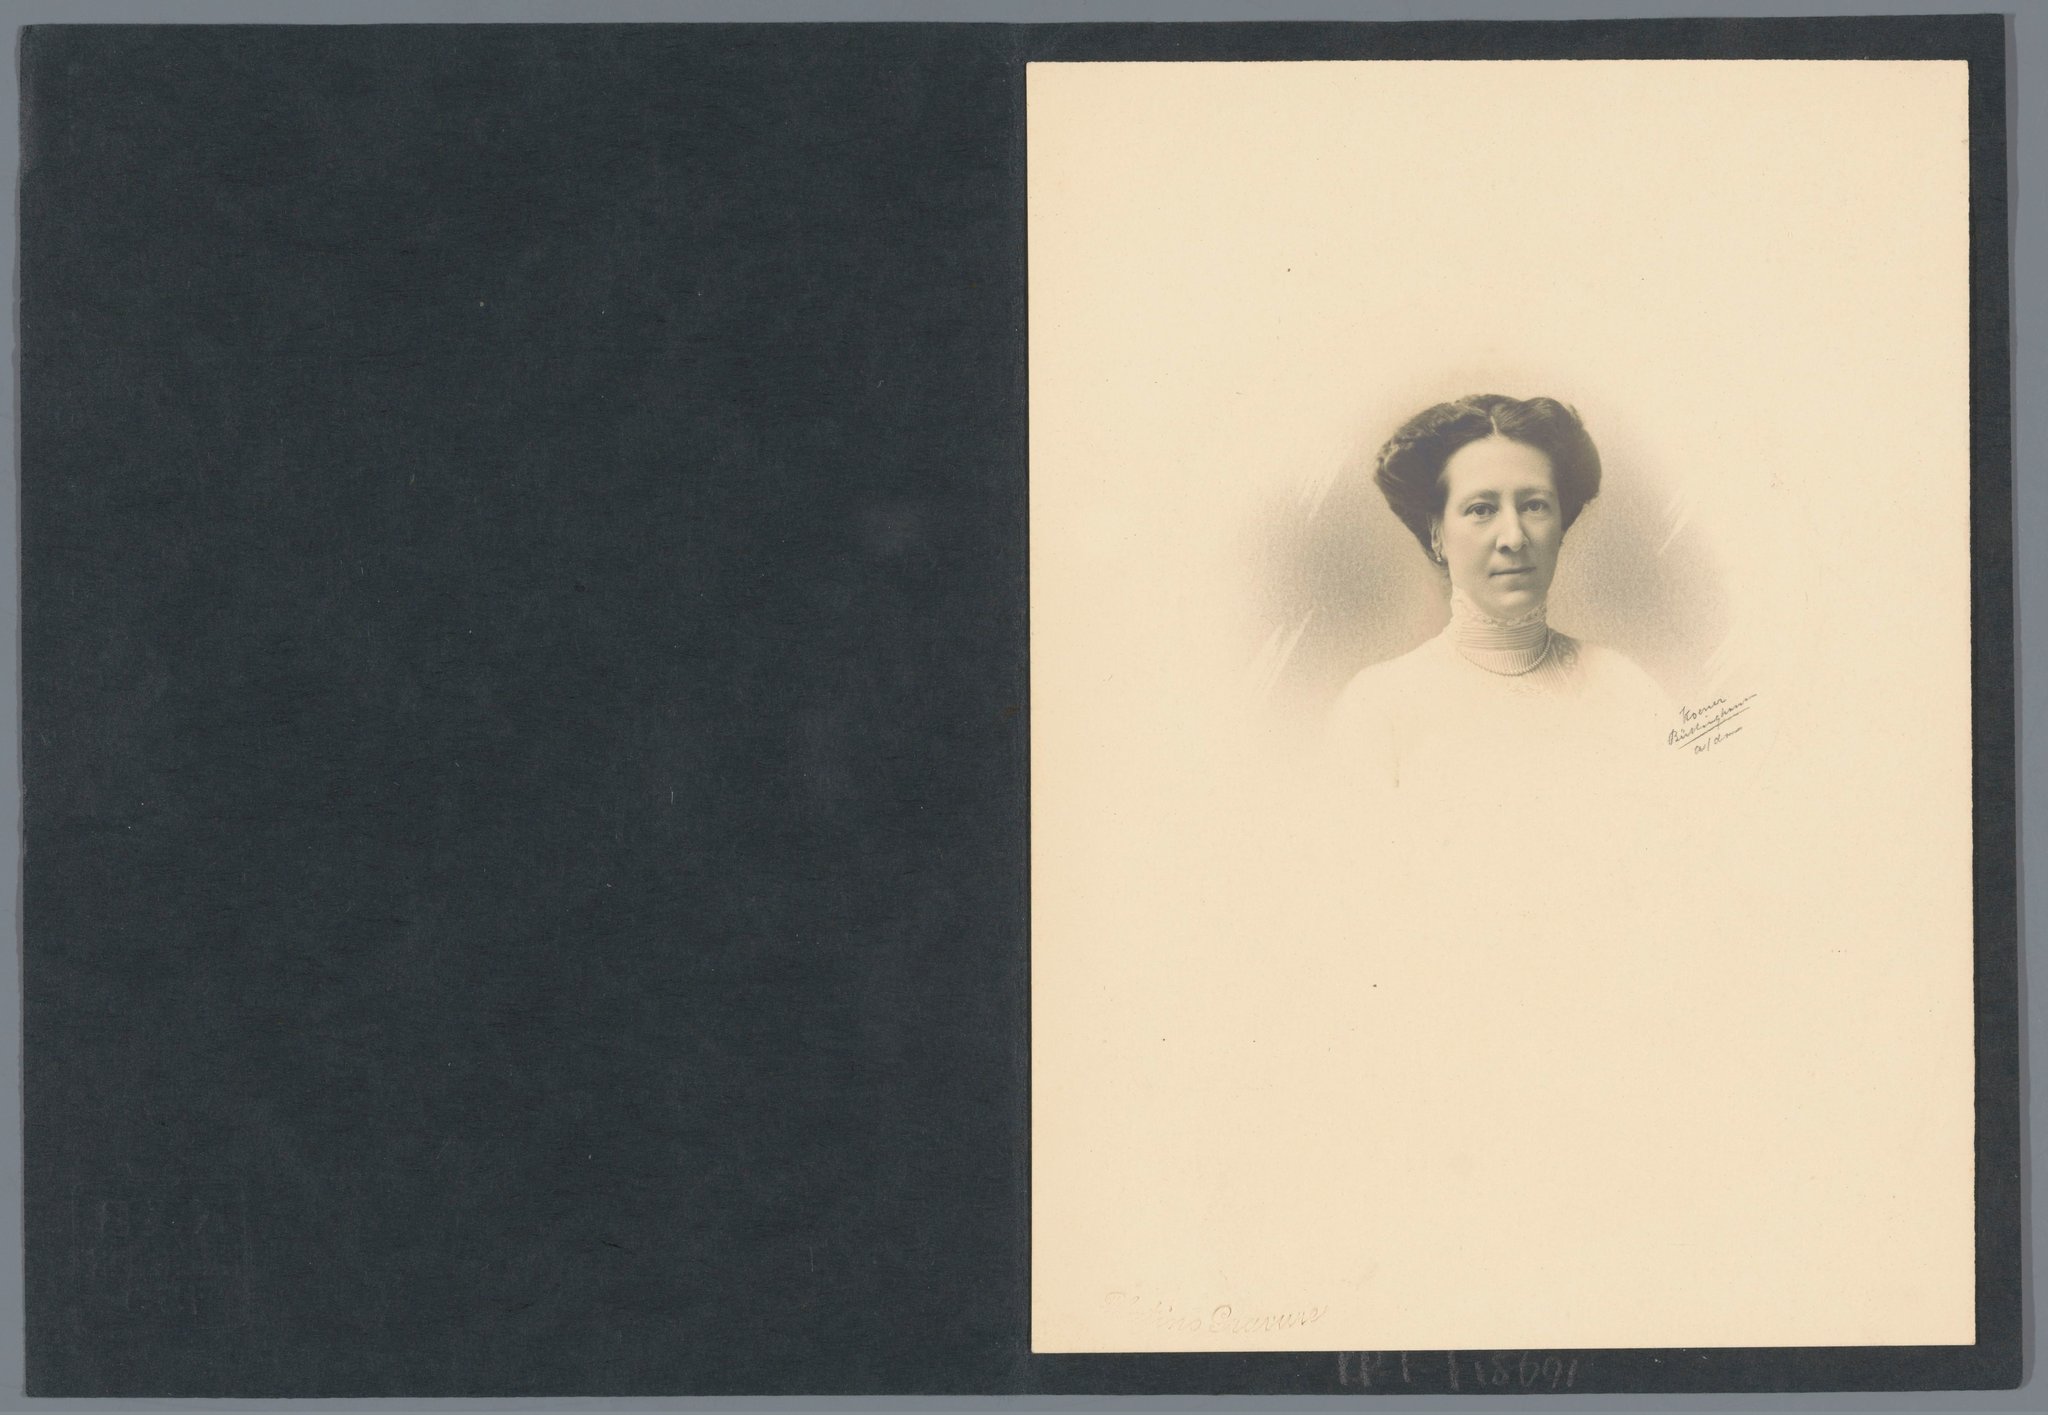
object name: photograph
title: Portret van een onbekende vrouw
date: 1905-1920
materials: photographic support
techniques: gelatin silver print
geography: amsterdam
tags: adult woman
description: Dezelfde vrouw is gefotografeerd op RP-F-F15692.